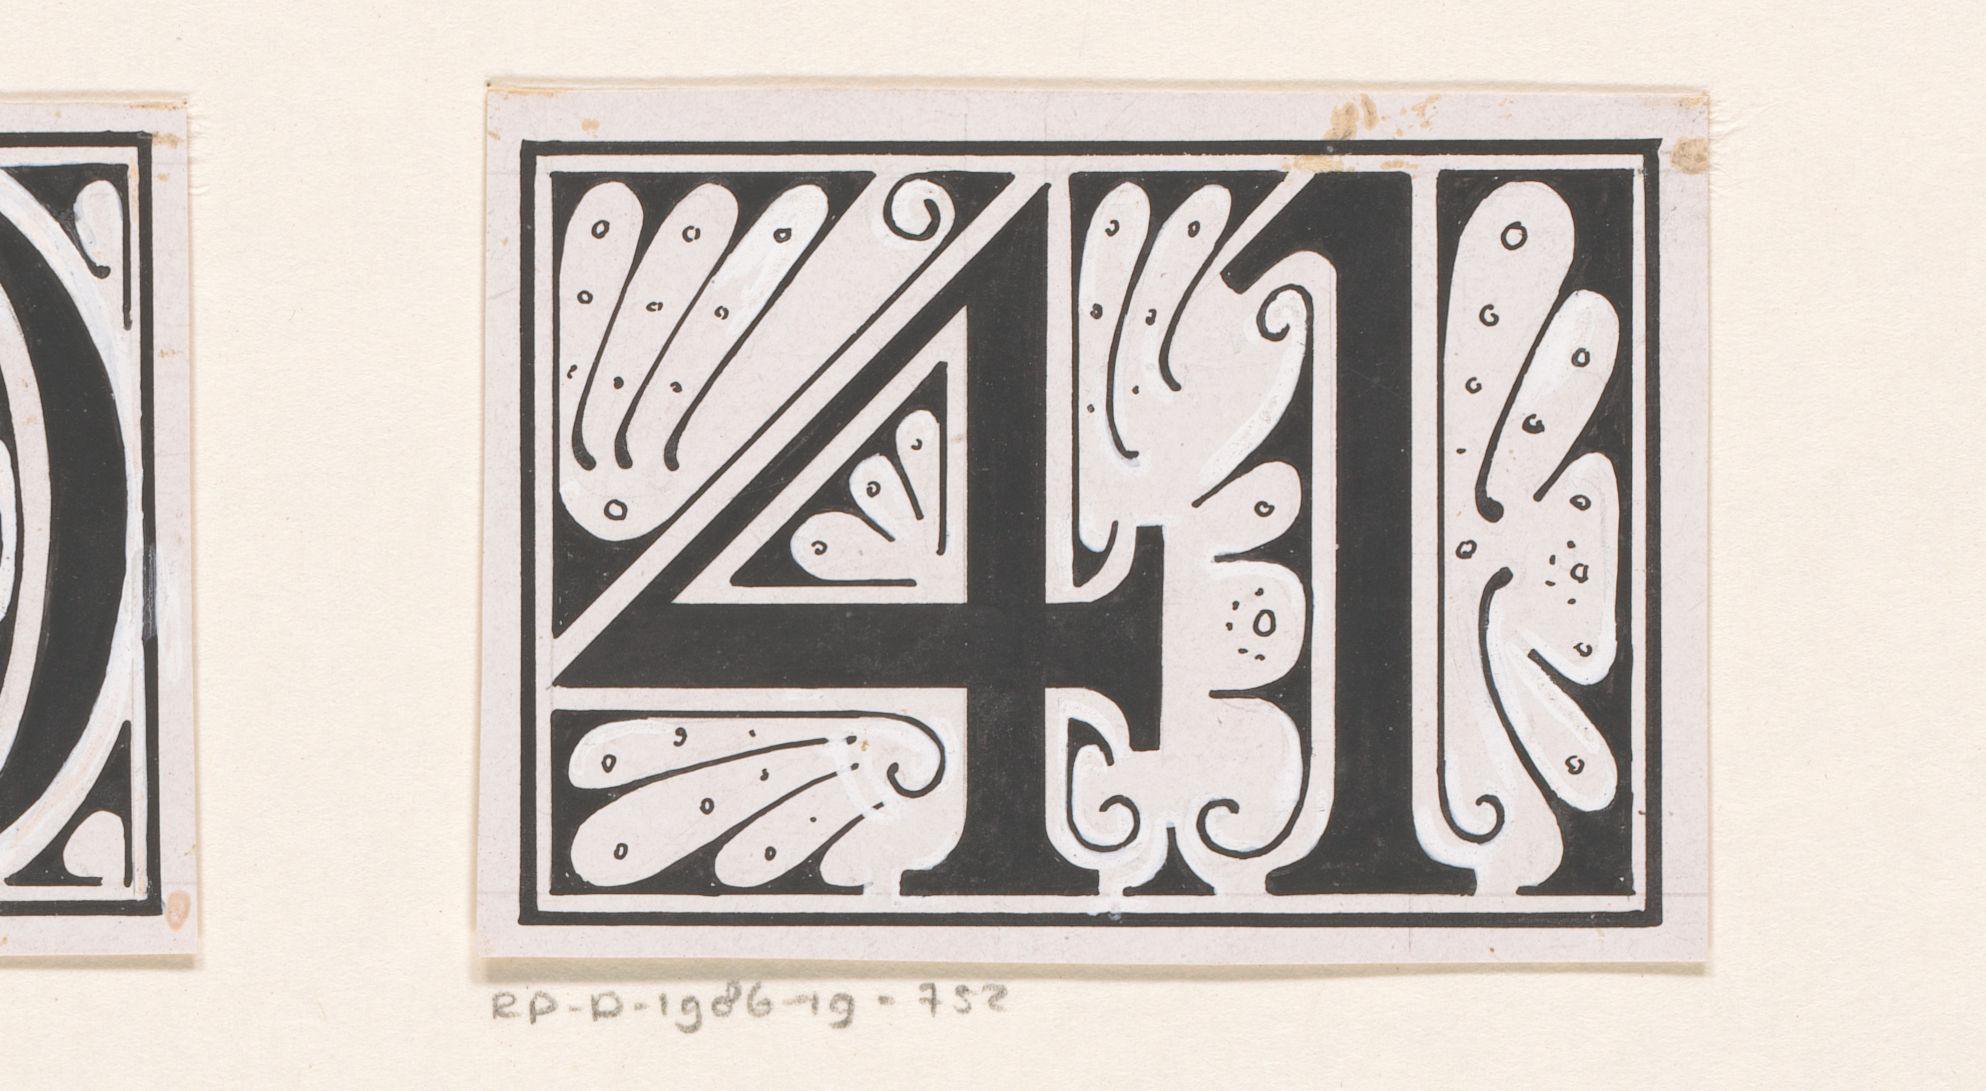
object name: design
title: Getal 41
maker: reinier willem petrus de vries (1874-1953)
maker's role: draughtsman, print maker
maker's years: 1874-1953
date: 1904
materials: paint, ink, paper, pencil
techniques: brush, pen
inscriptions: collector's mark: ‘R:MVS.’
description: Het getal is gebruikt voor: Veth, Jan. Jozef Israëls en zijn kunst. Arnhem en Nijmegen: Gebroeders E&M Cohen, 1904.